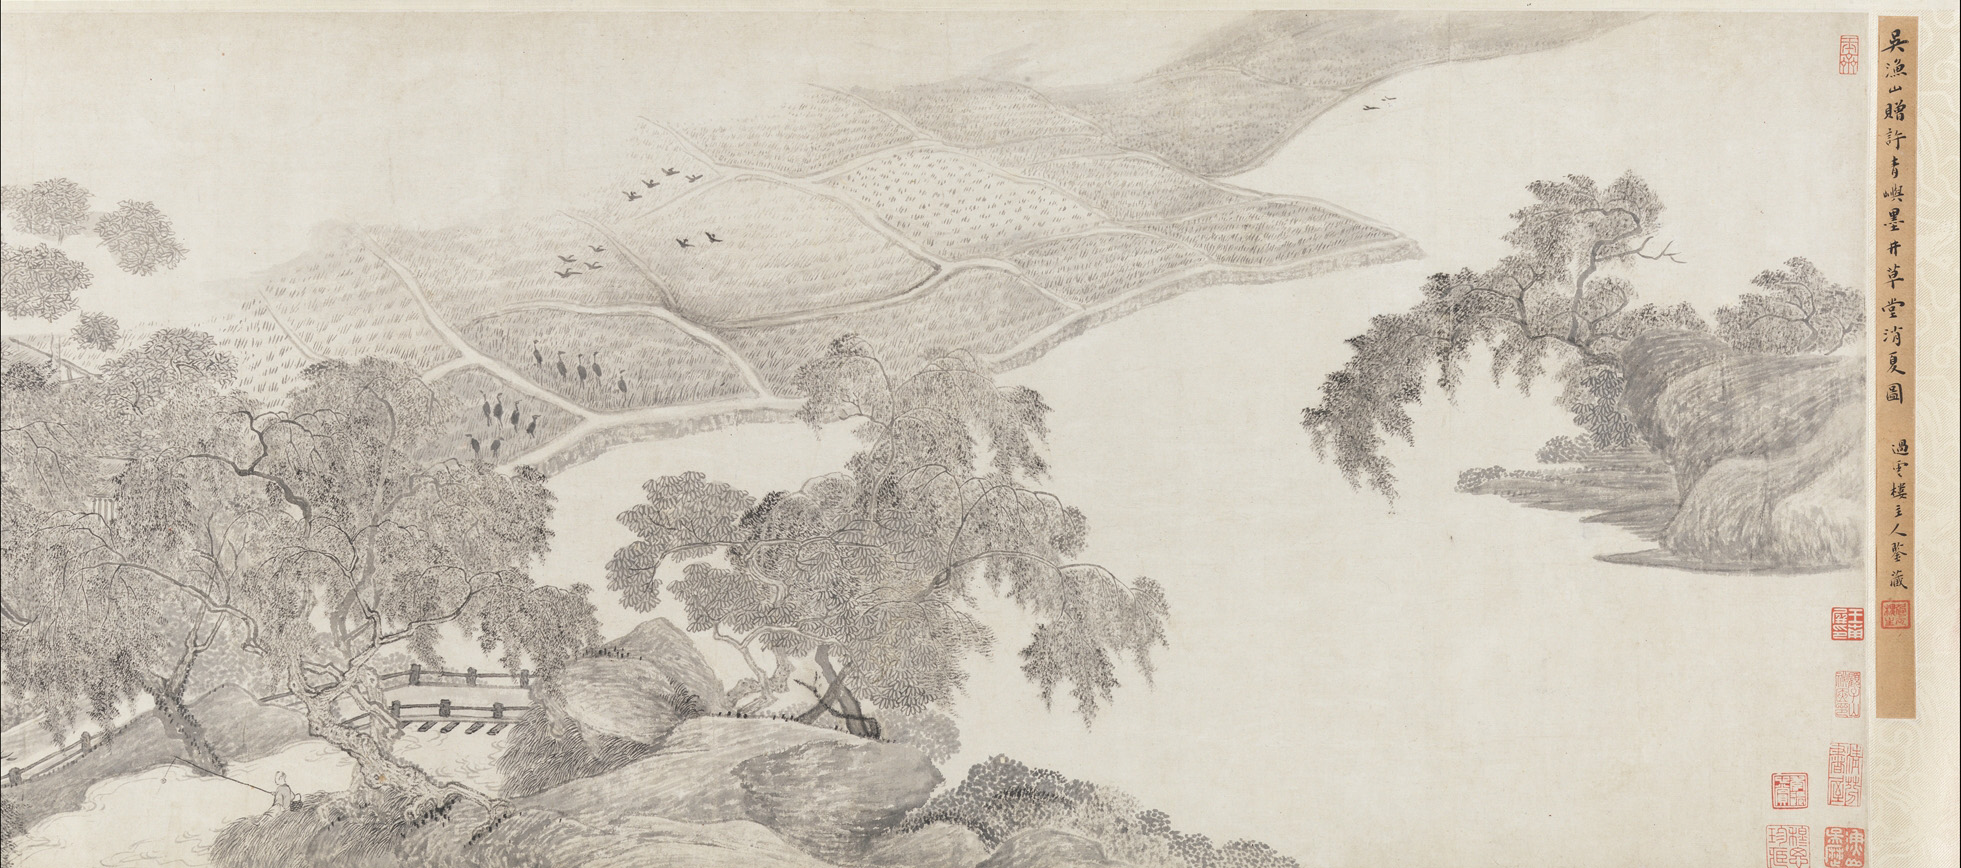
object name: handscroll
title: Whiling Away the Summer at the Ink-Well Thatched Hut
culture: chinese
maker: wu li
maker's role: artist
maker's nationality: chinese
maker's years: 1632-1718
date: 1679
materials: ink, paper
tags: birds,rivers,landscapes